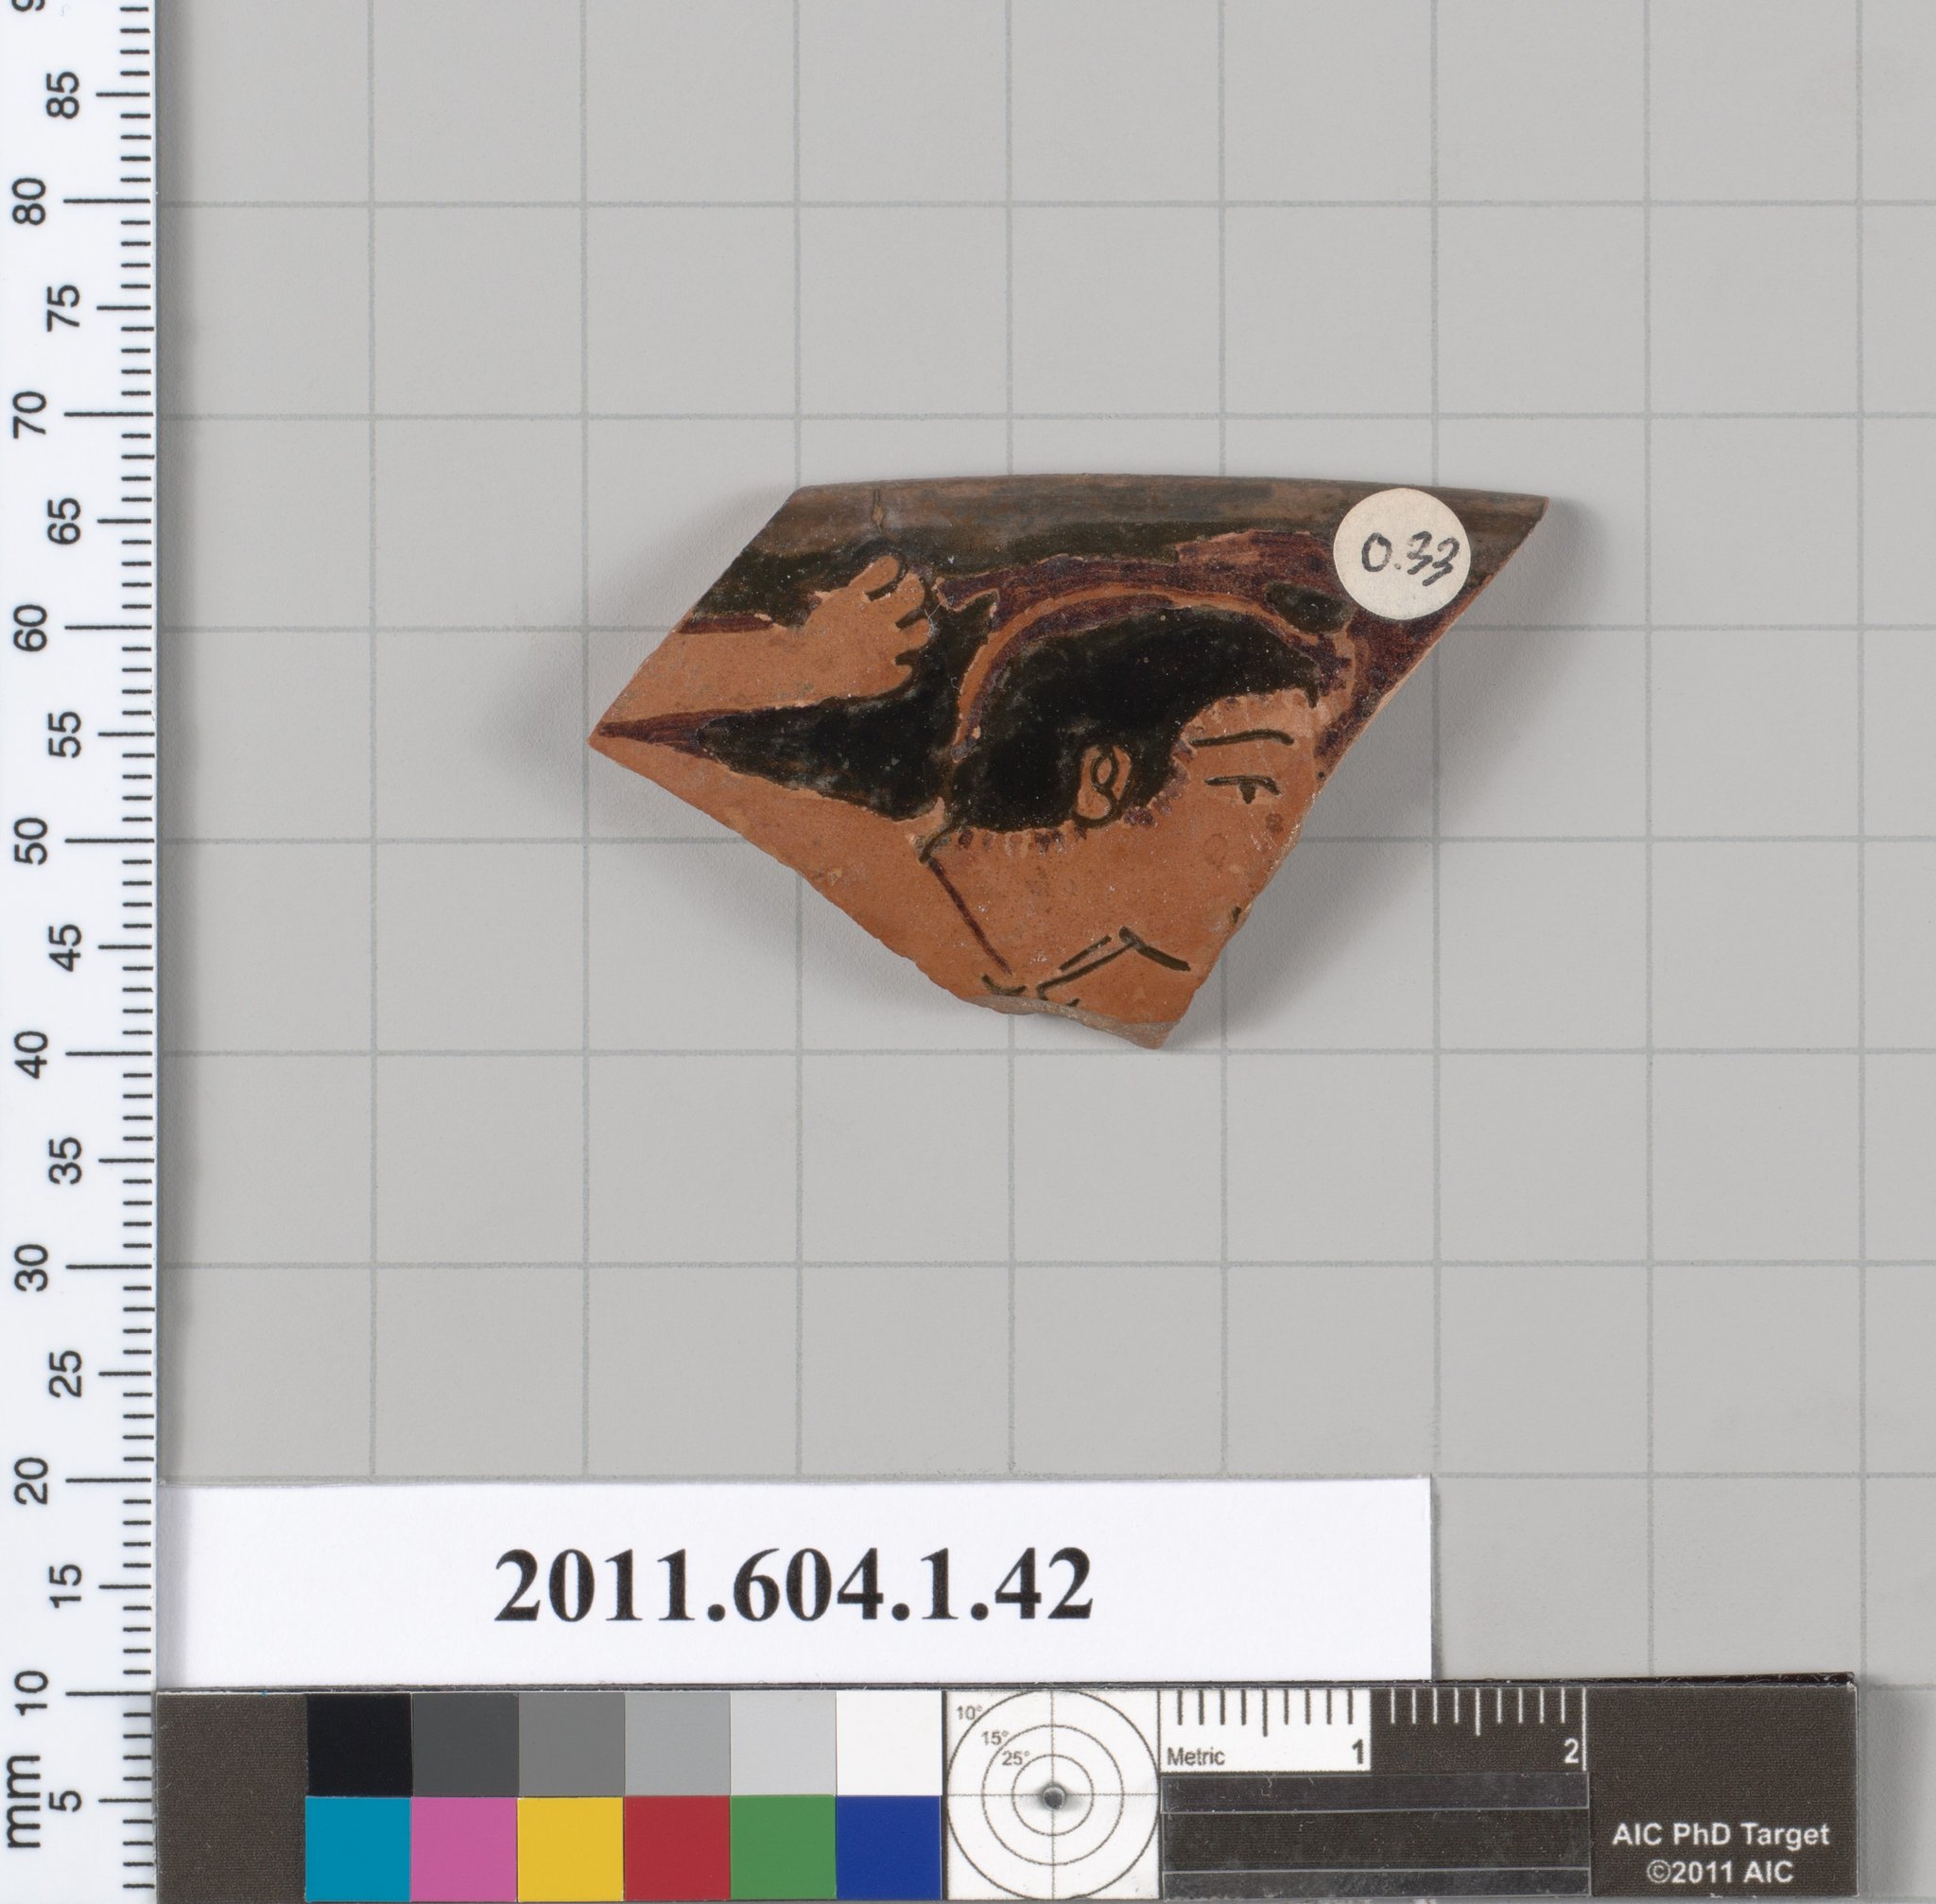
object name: kylix fragment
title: Terracotta rim fragment of a kylix (drinking cup)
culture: greek, attic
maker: triptolemos painter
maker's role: artist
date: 480-470 BCE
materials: terracotta